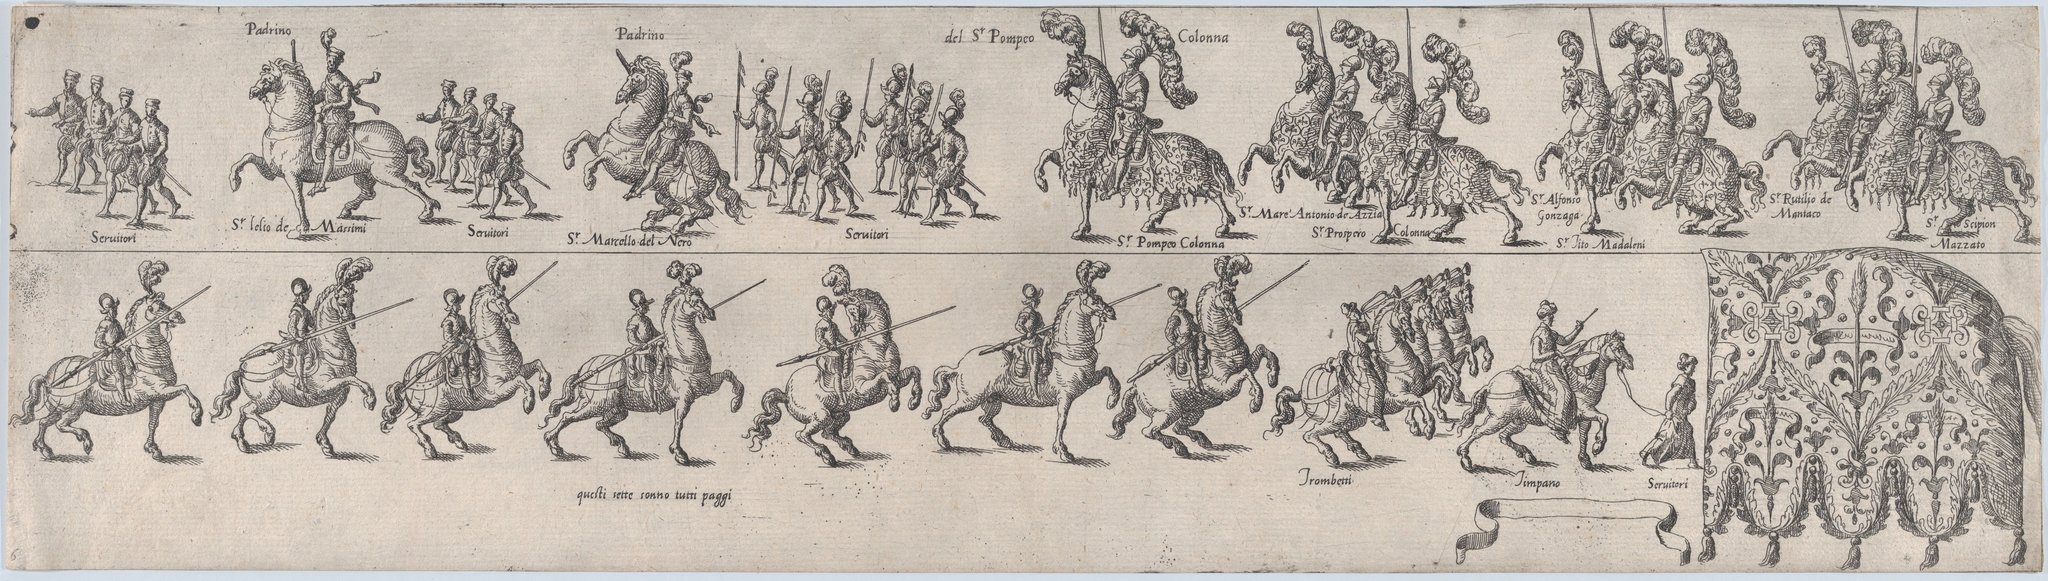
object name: print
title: Plate depicting Pompeo Colonna, from a series of twelve showing knights and their attendants dressed for a tournament (plate 6)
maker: Anonymous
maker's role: artist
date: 1565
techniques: etching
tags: spears,men,horses,knights